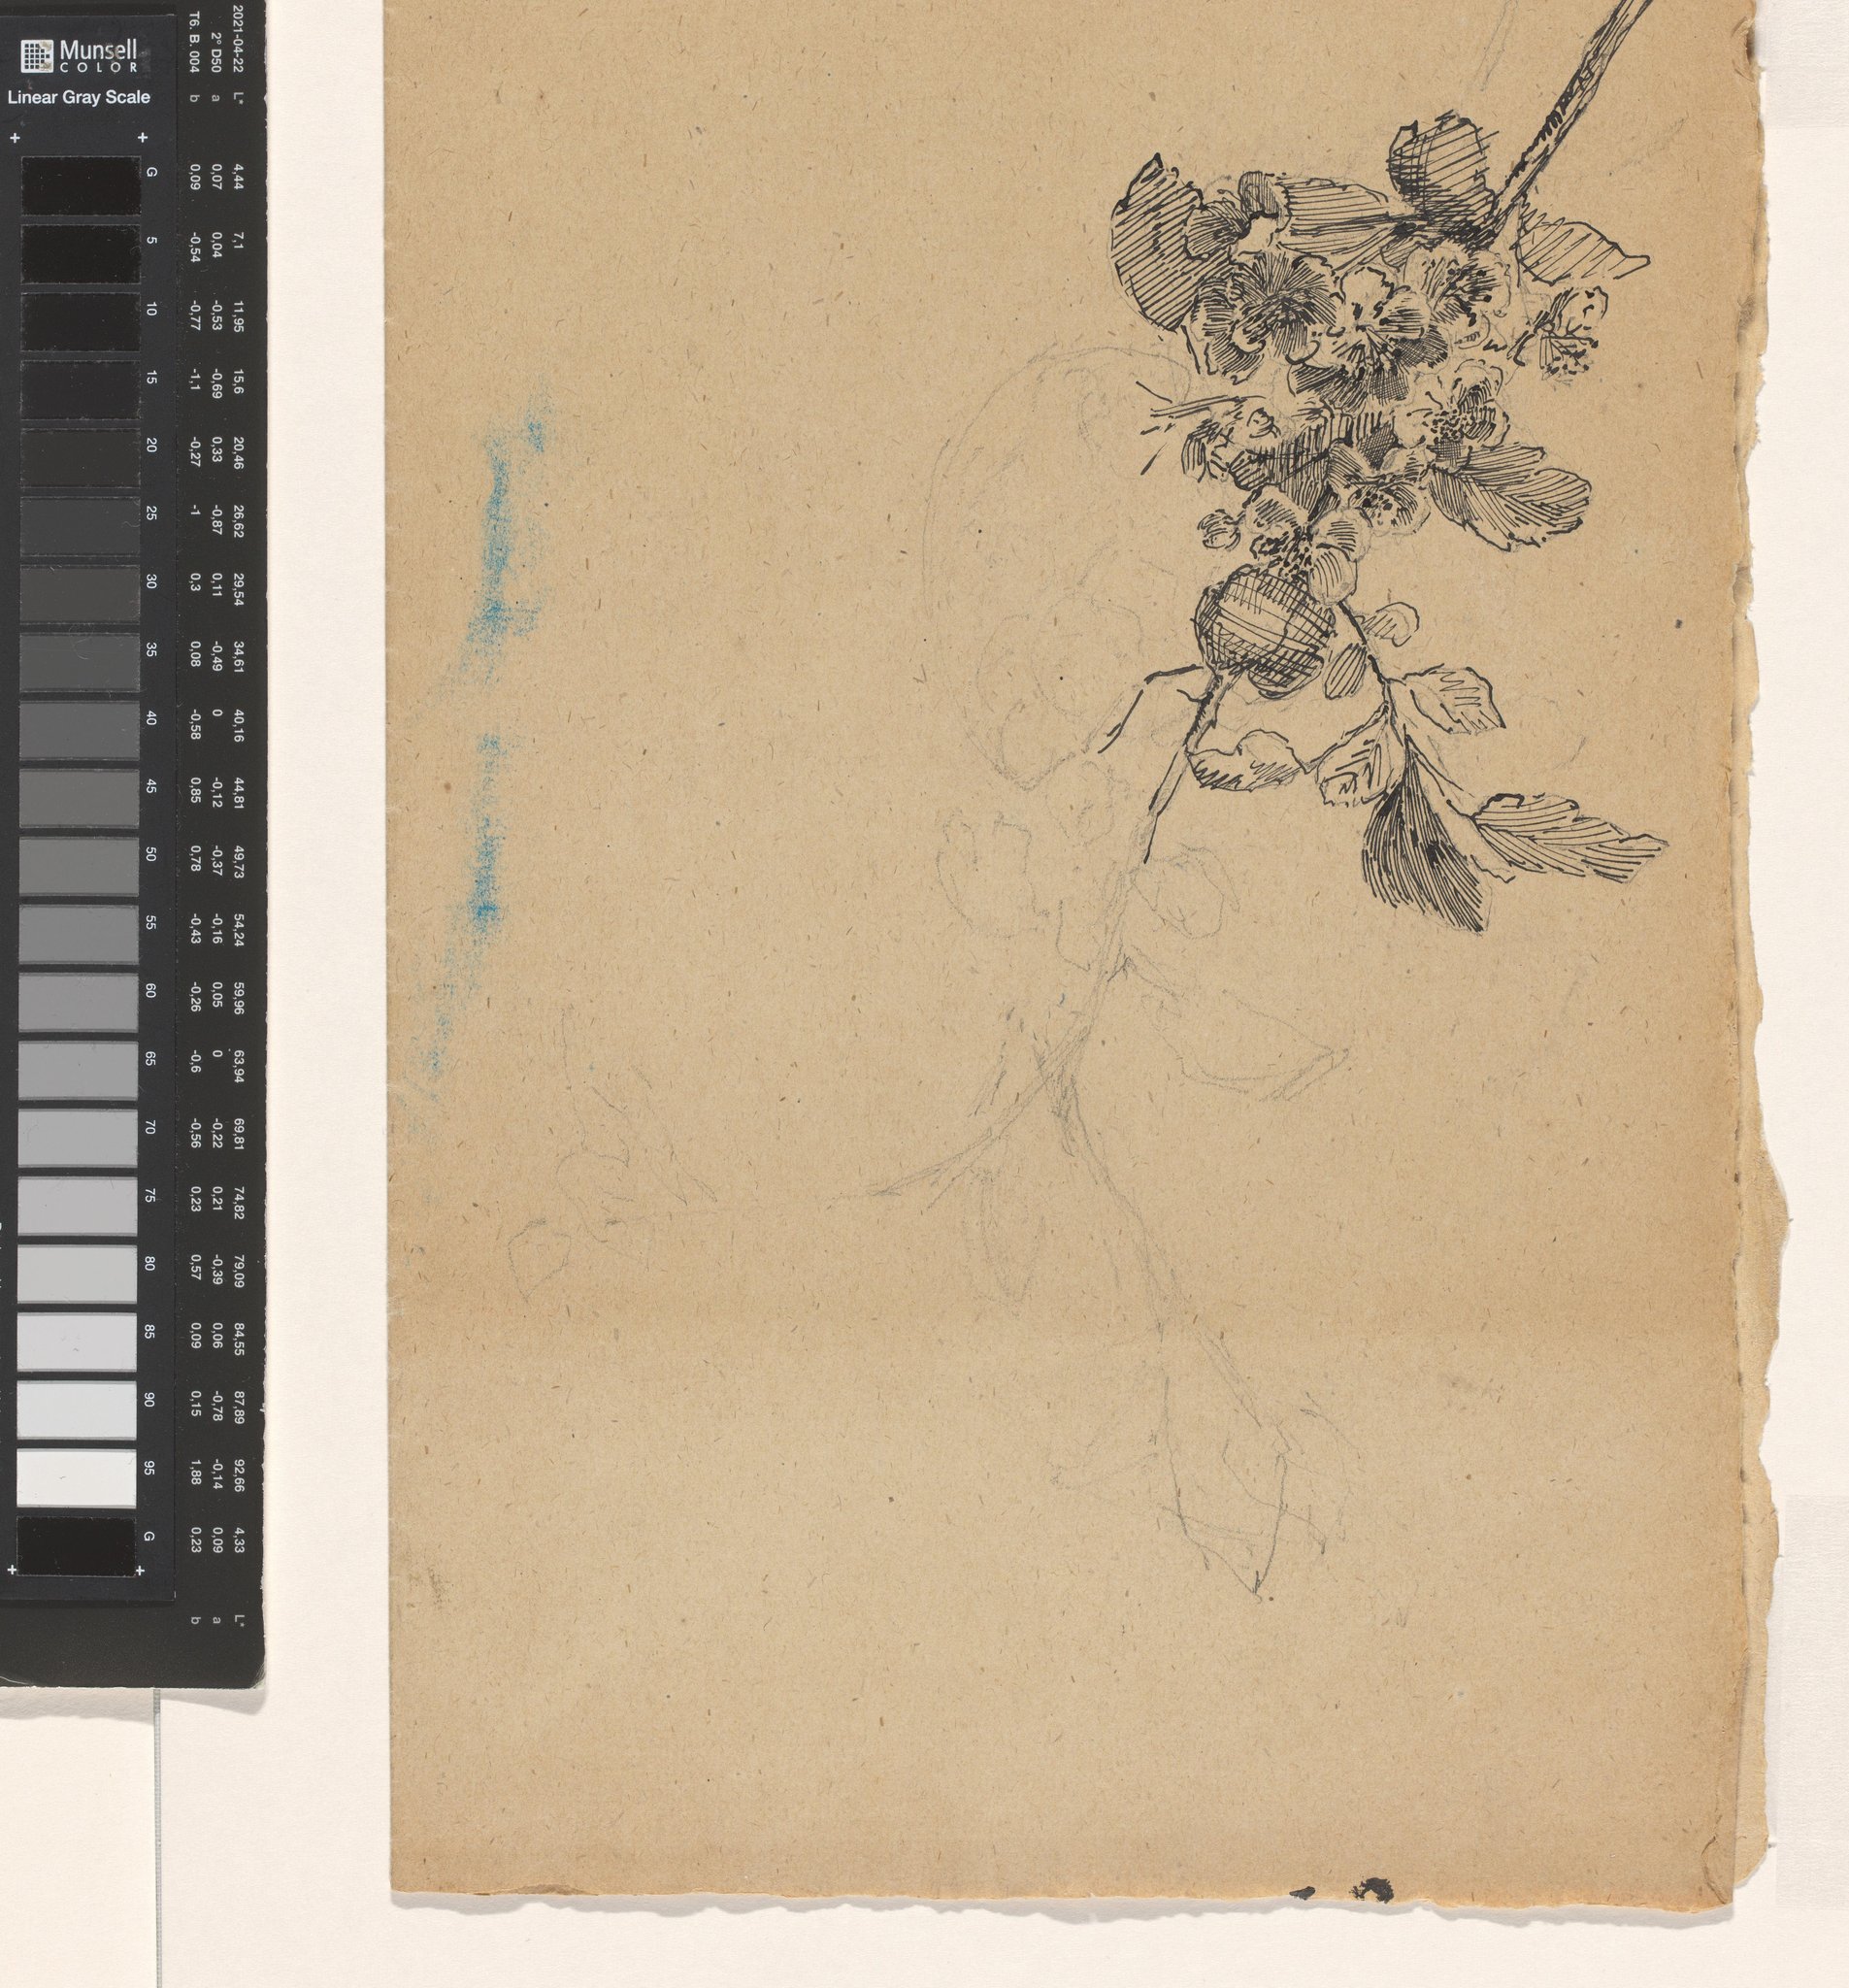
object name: schetsblad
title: Bloesem en bomen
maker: johanna behrend-croiset van der kop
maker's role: draughtsman, painter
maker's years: 1861-1943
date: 1880-1900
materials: ink, paper, pencil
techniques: pen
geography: netherlands